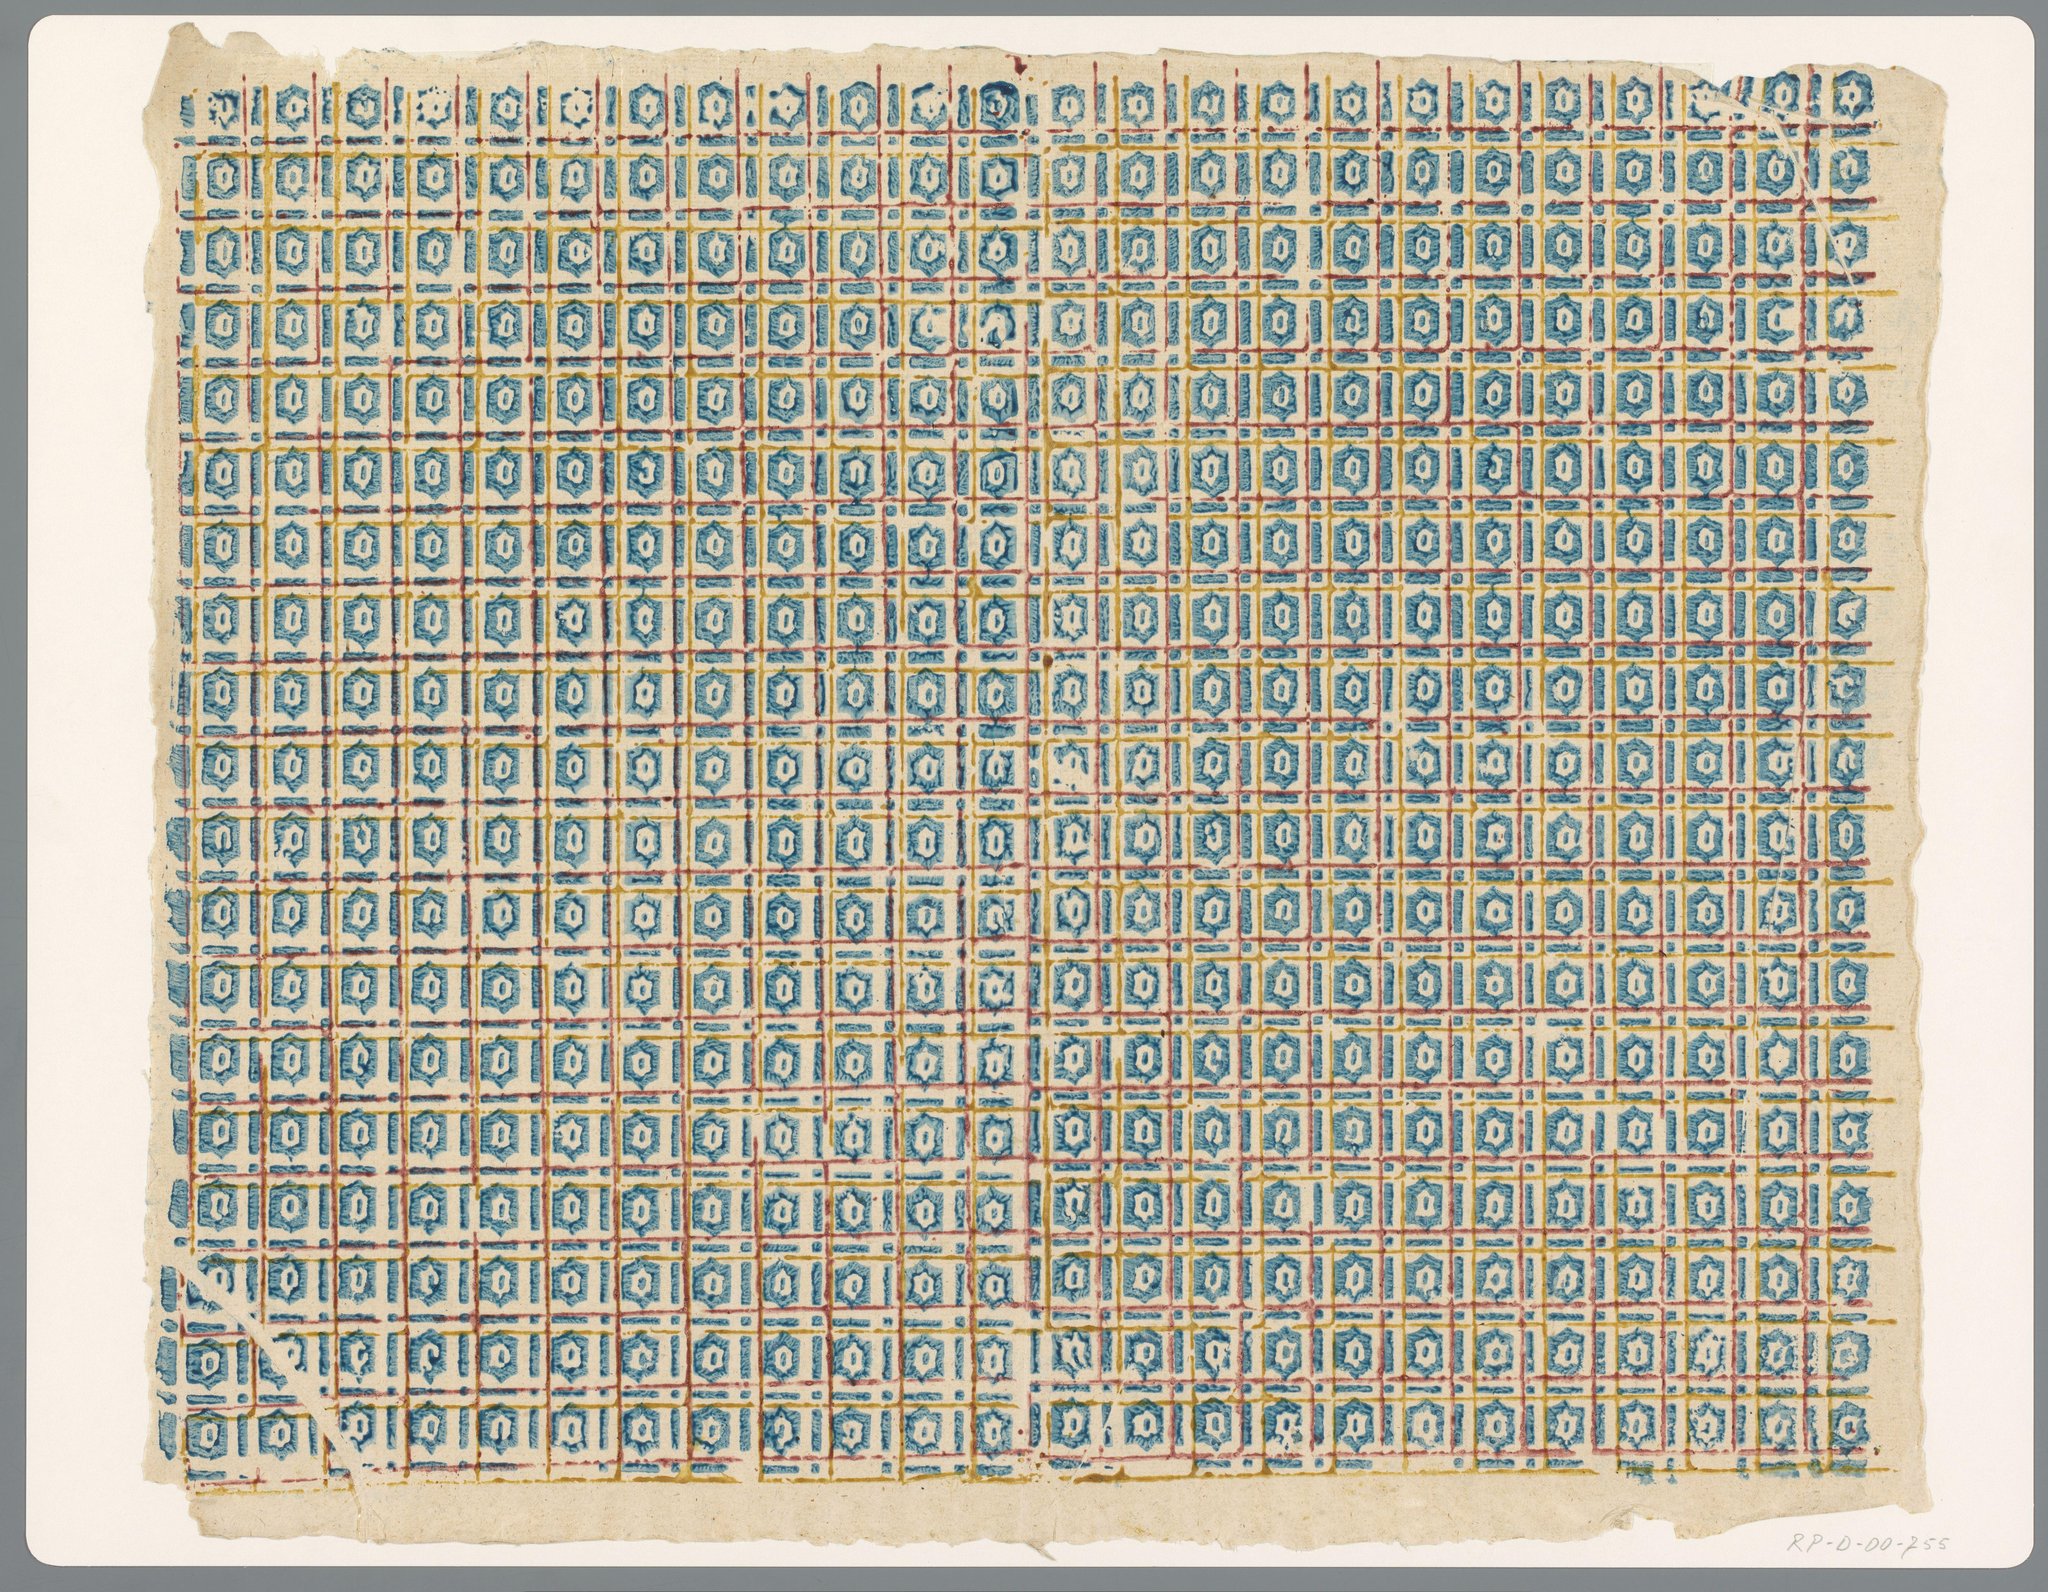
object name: printed paper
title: Blad met schaakbordpatroon met bladachtig motief tussen dubbele lijnen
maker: Anonymous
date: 1750-1950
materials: lacquer, paper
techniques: printing block, lacquer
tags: fantasy ornament